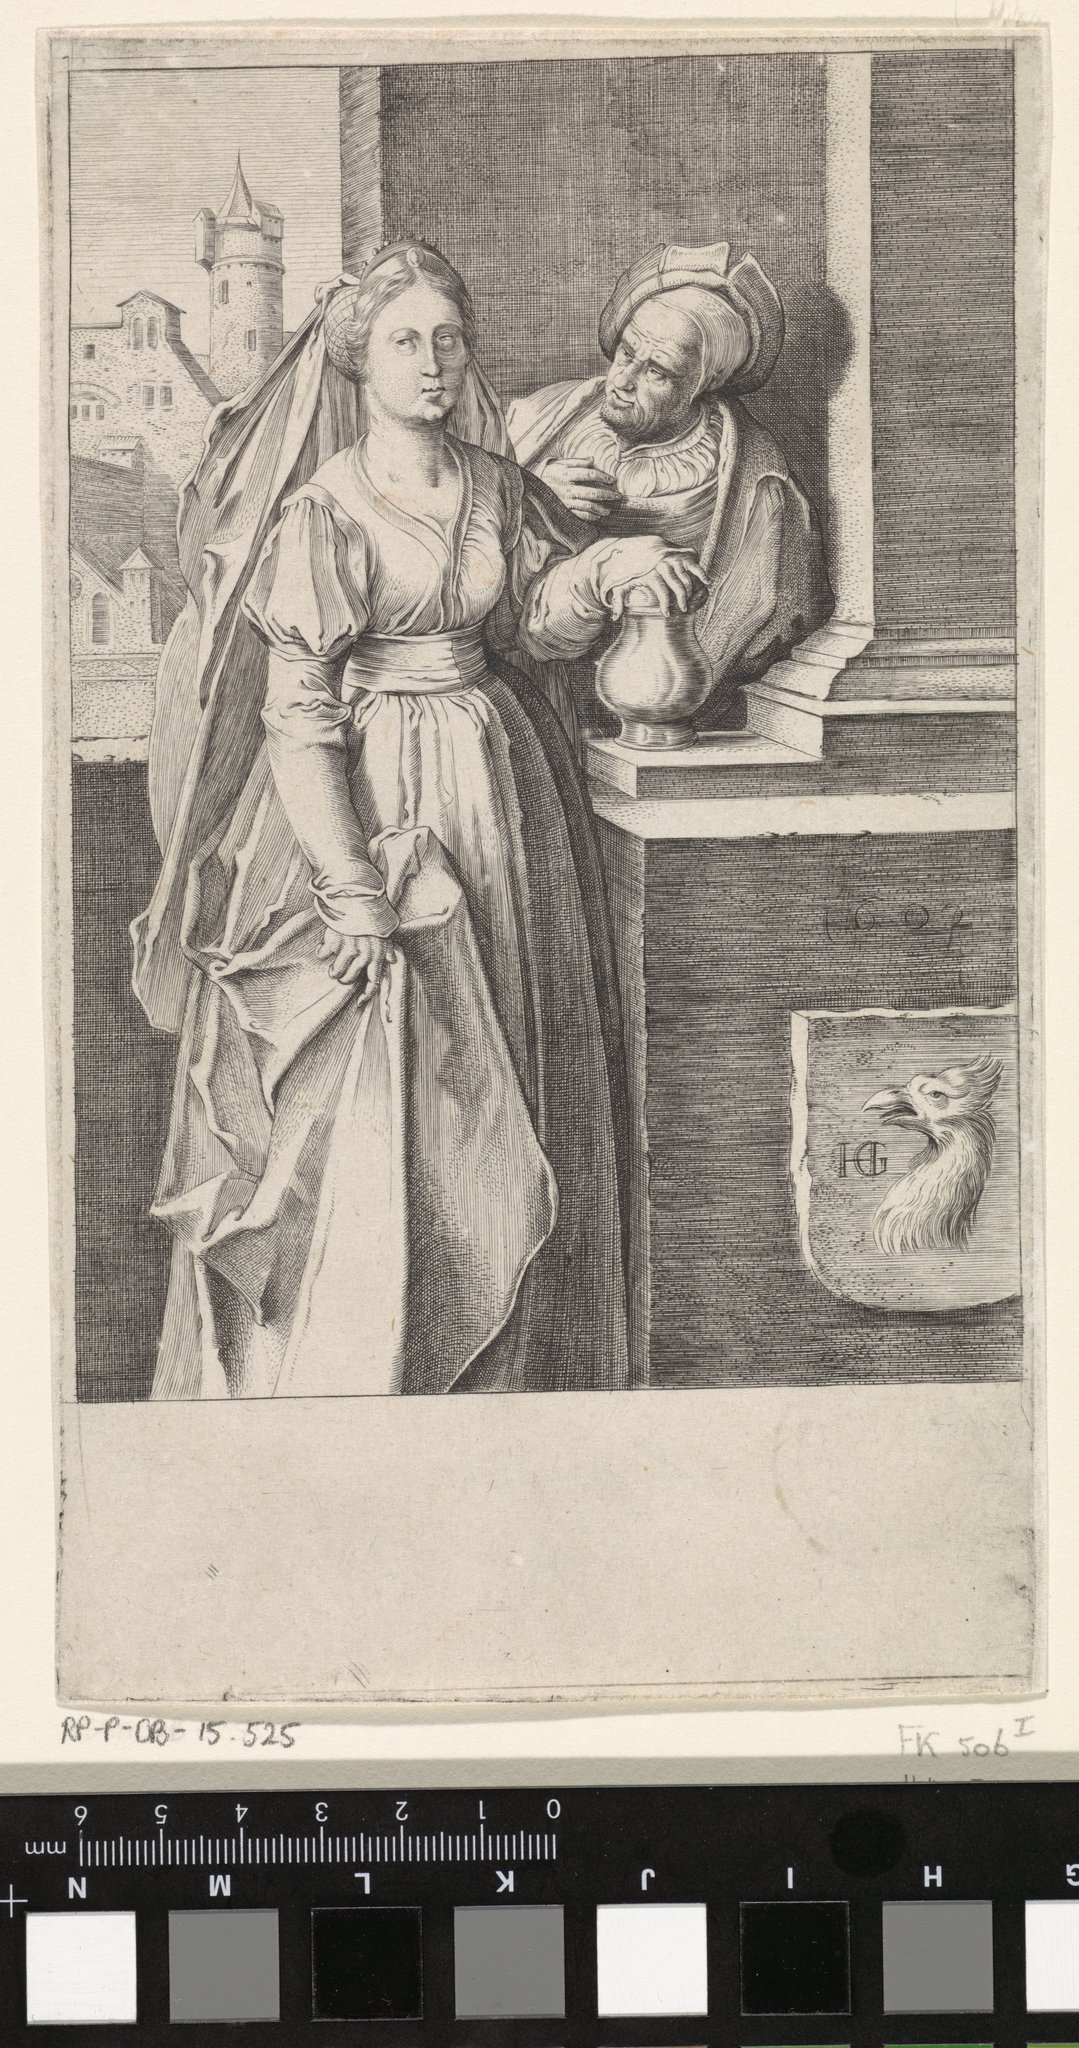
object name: print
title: Ongelijke liefde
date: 1602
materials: paper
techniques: engraving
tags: unequal couple, ill-matched couple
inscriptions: collector's mark: Lugt 240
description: Een oude man benadert een jonge vrouw, die haar hand op een kruik houdt. Ze draagt een sluier in haar haar. Op de stenen zuil het wapenschild van de familie Goltzius.